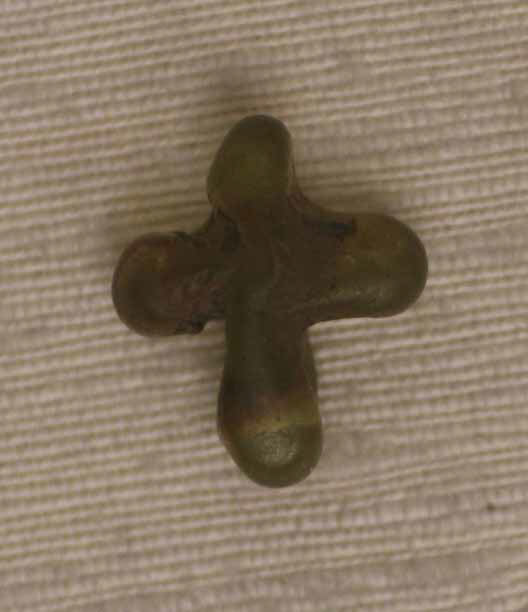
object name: cross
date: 201-1200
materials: glass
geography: egypt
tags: cross